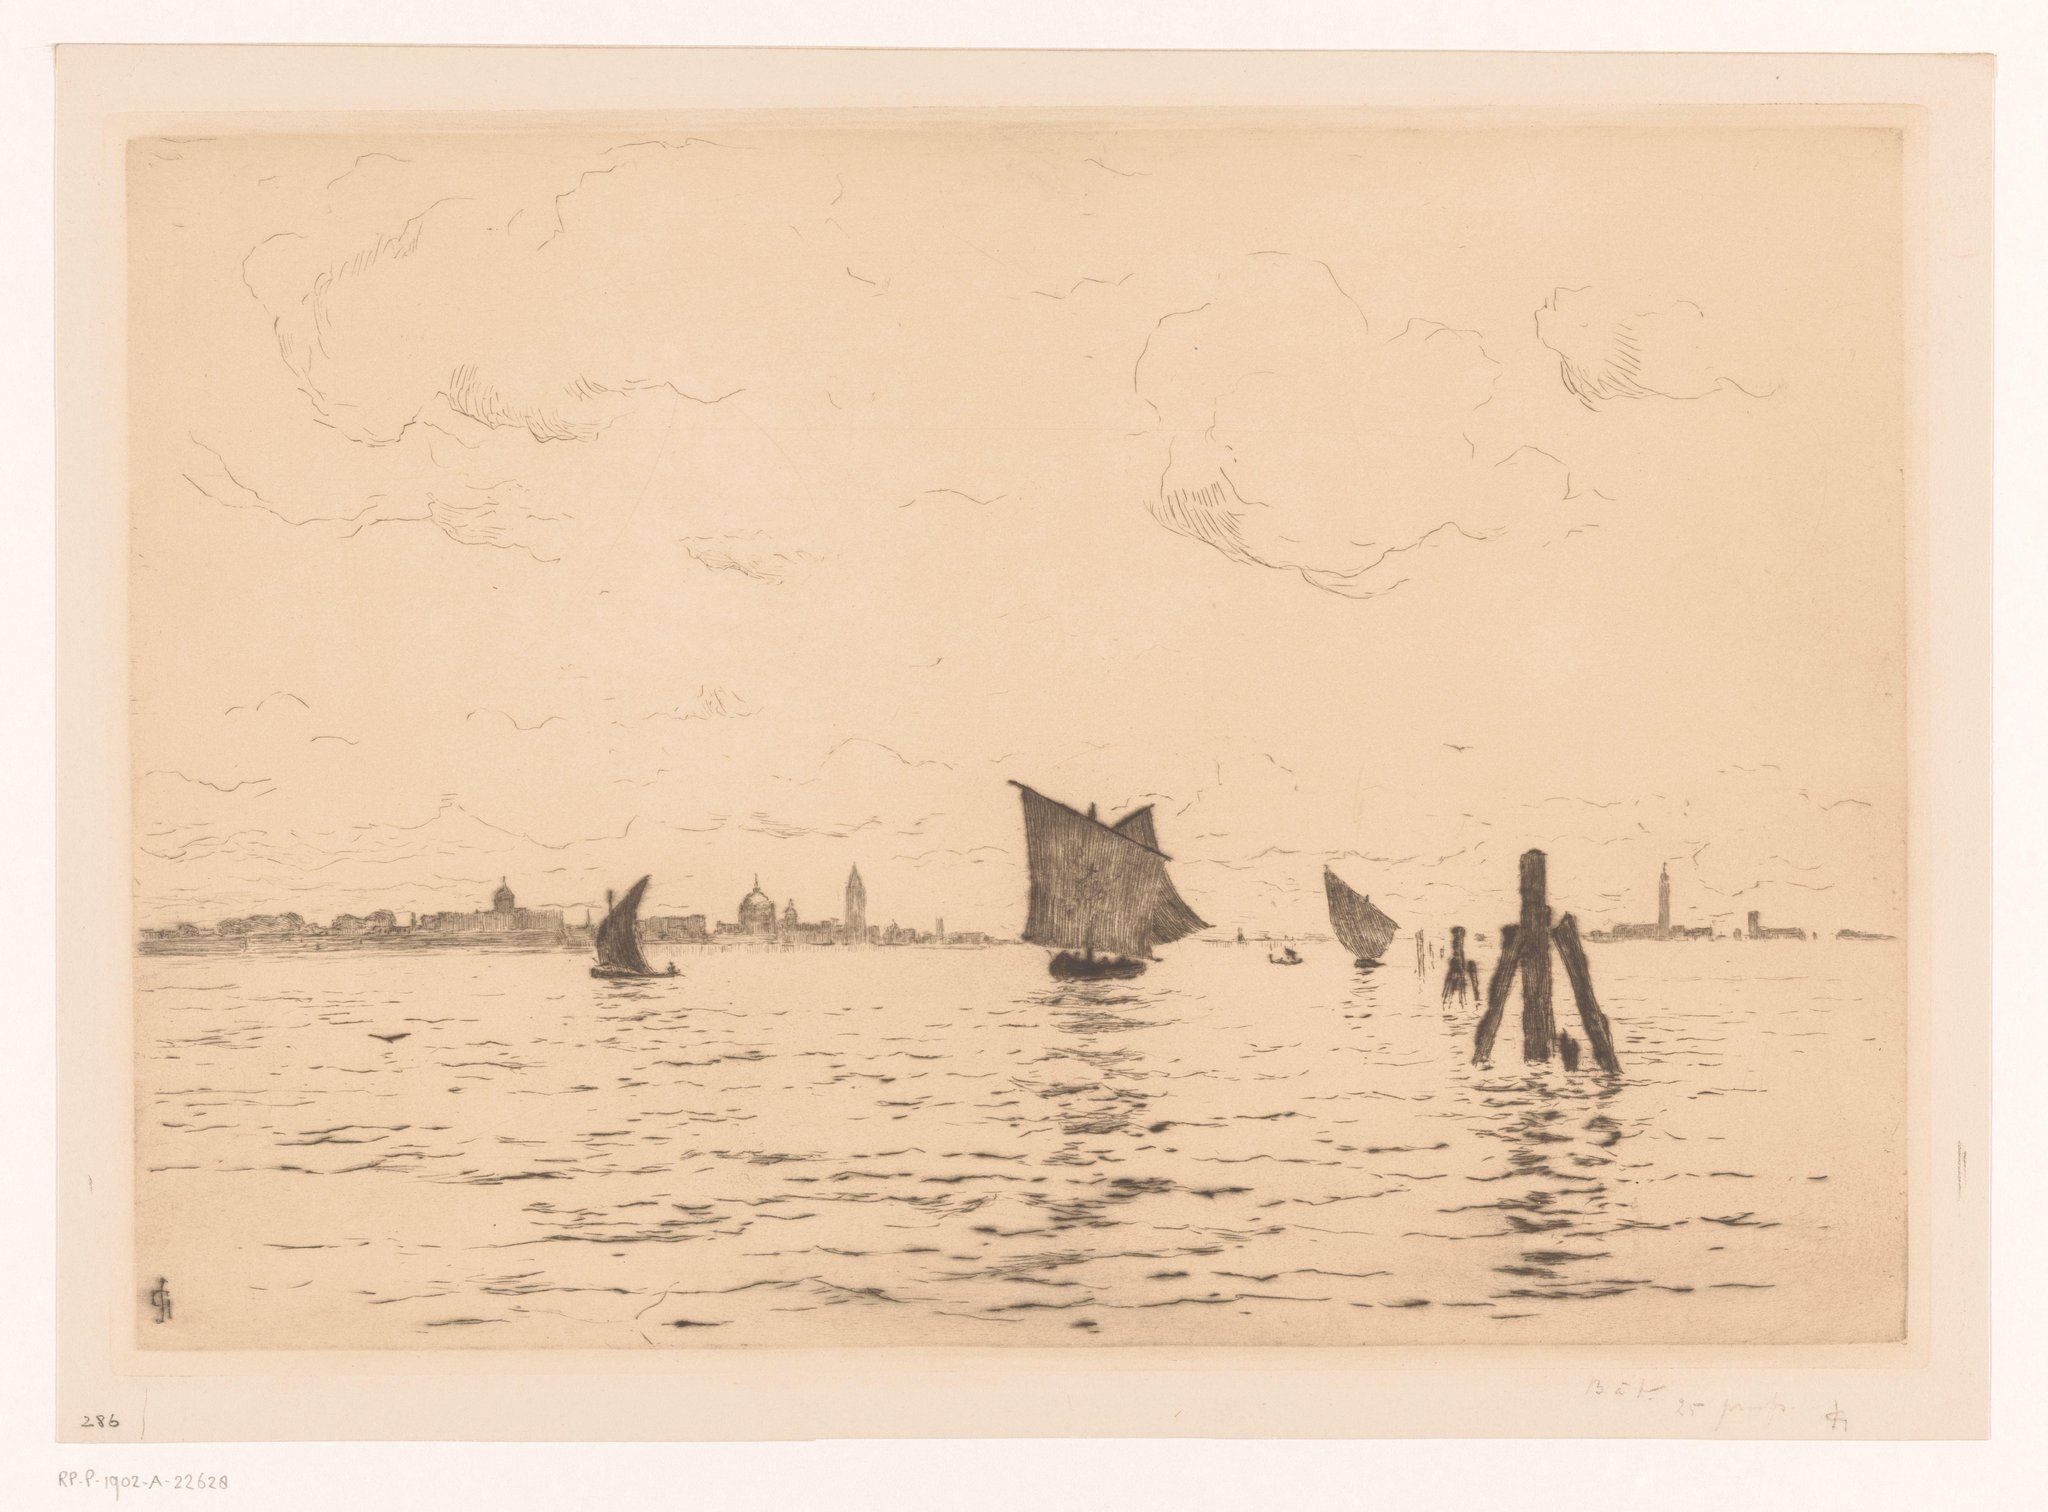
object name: print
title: Gezicht op de Lagune van Venetië voor Murano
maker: carel nicolaas storm van s-gravesande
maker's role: draughtsman, print maker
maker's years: 1841-1924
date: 1889-1902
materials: paper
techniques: drypoint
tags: haff, lagoon created by sand, shingle bank ~ coast, prospect of city, town panorama, silhouette of city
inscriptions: inscription: ‘B à [...] 25 proofs’, collector's mark: Lugt 2228, number: ‘286’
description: Mogelijk vermeld in: Storm van 's-Gravesande, Charles. Catalogue des eaux-fortes et lithographies. New York: s.n., 1903, of in een onbekende latere uitgave van het manuscript. Vermoedelijk vermeld als catalogusnummer 286.